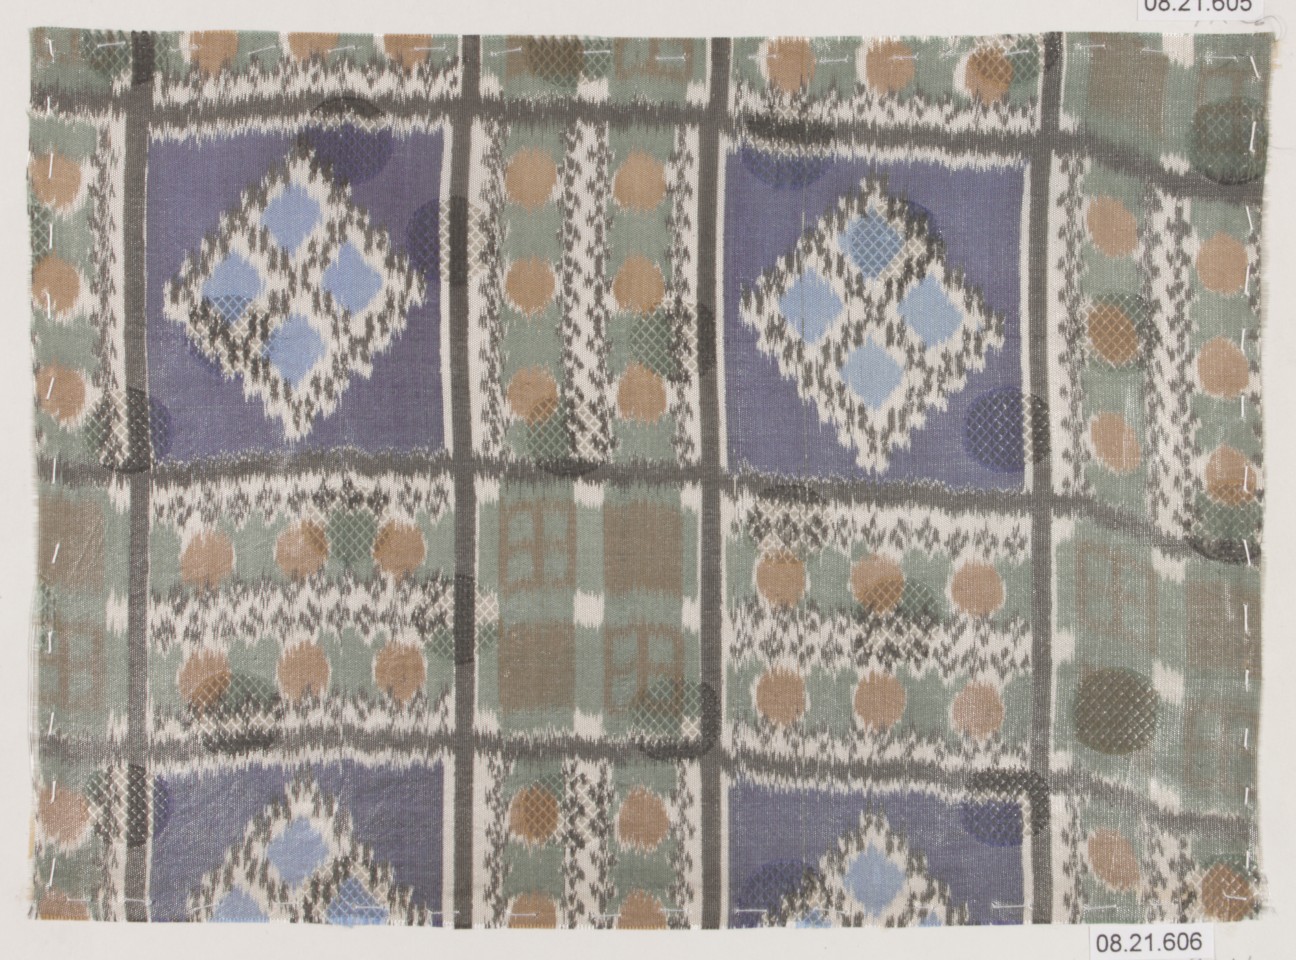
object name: textile sample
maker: Anonymous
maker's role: designer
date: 1900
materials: silk